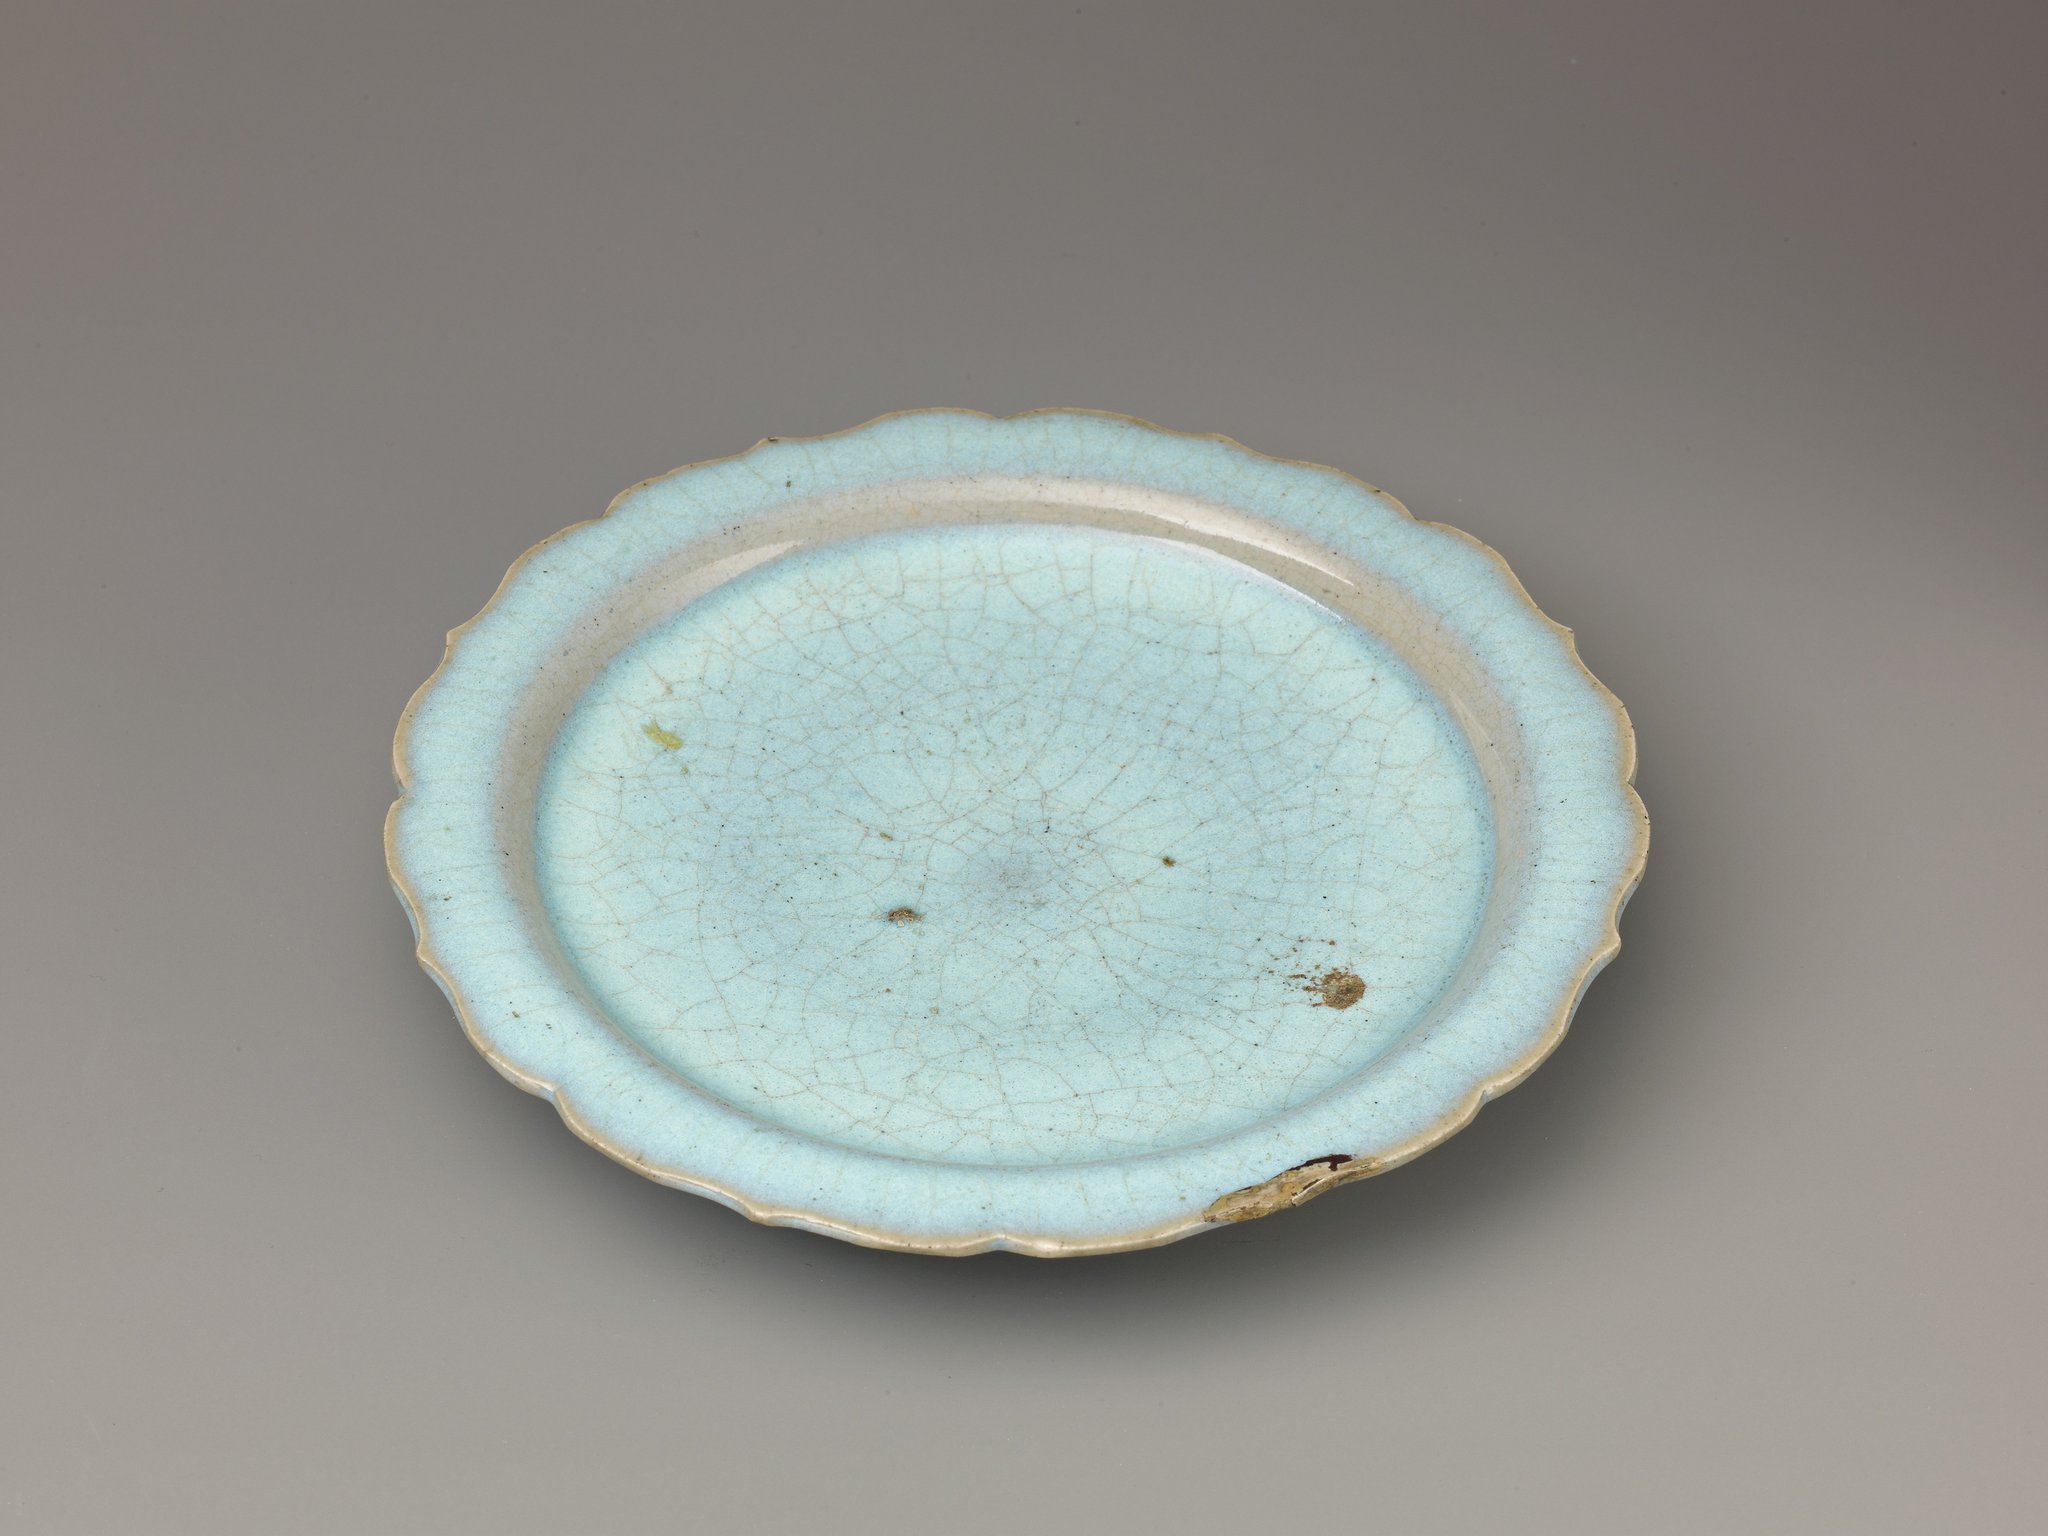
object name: plate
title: Foliate-rim plate, Jun ware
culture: chinese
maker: chinese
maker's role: artist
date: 1201-1300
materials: glaze, stoneware